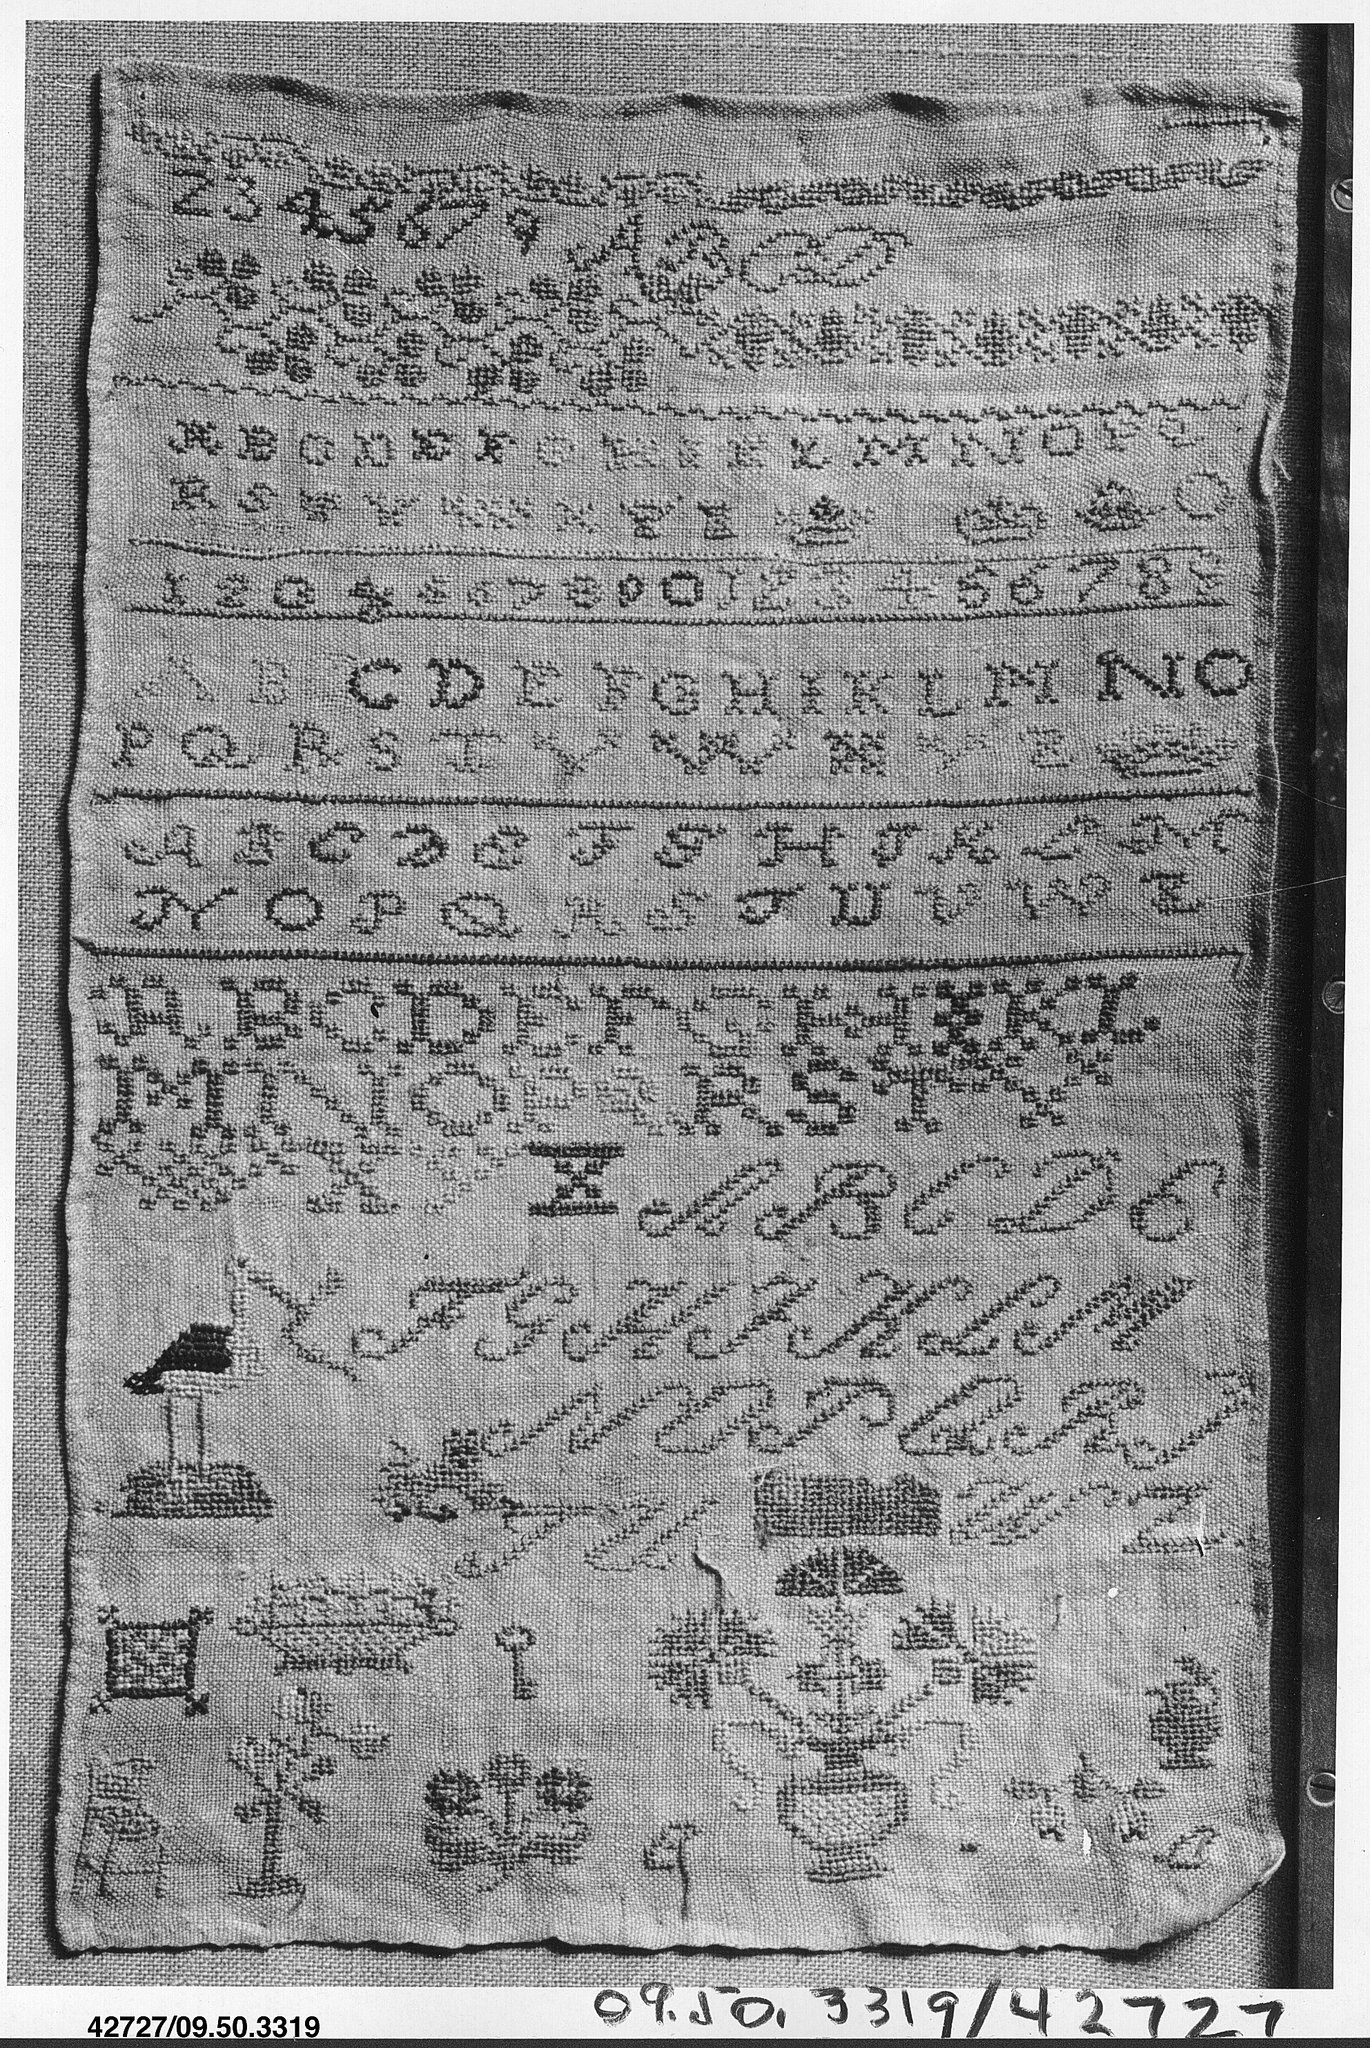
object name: sampler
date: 1701-1800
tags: cranes,flowers